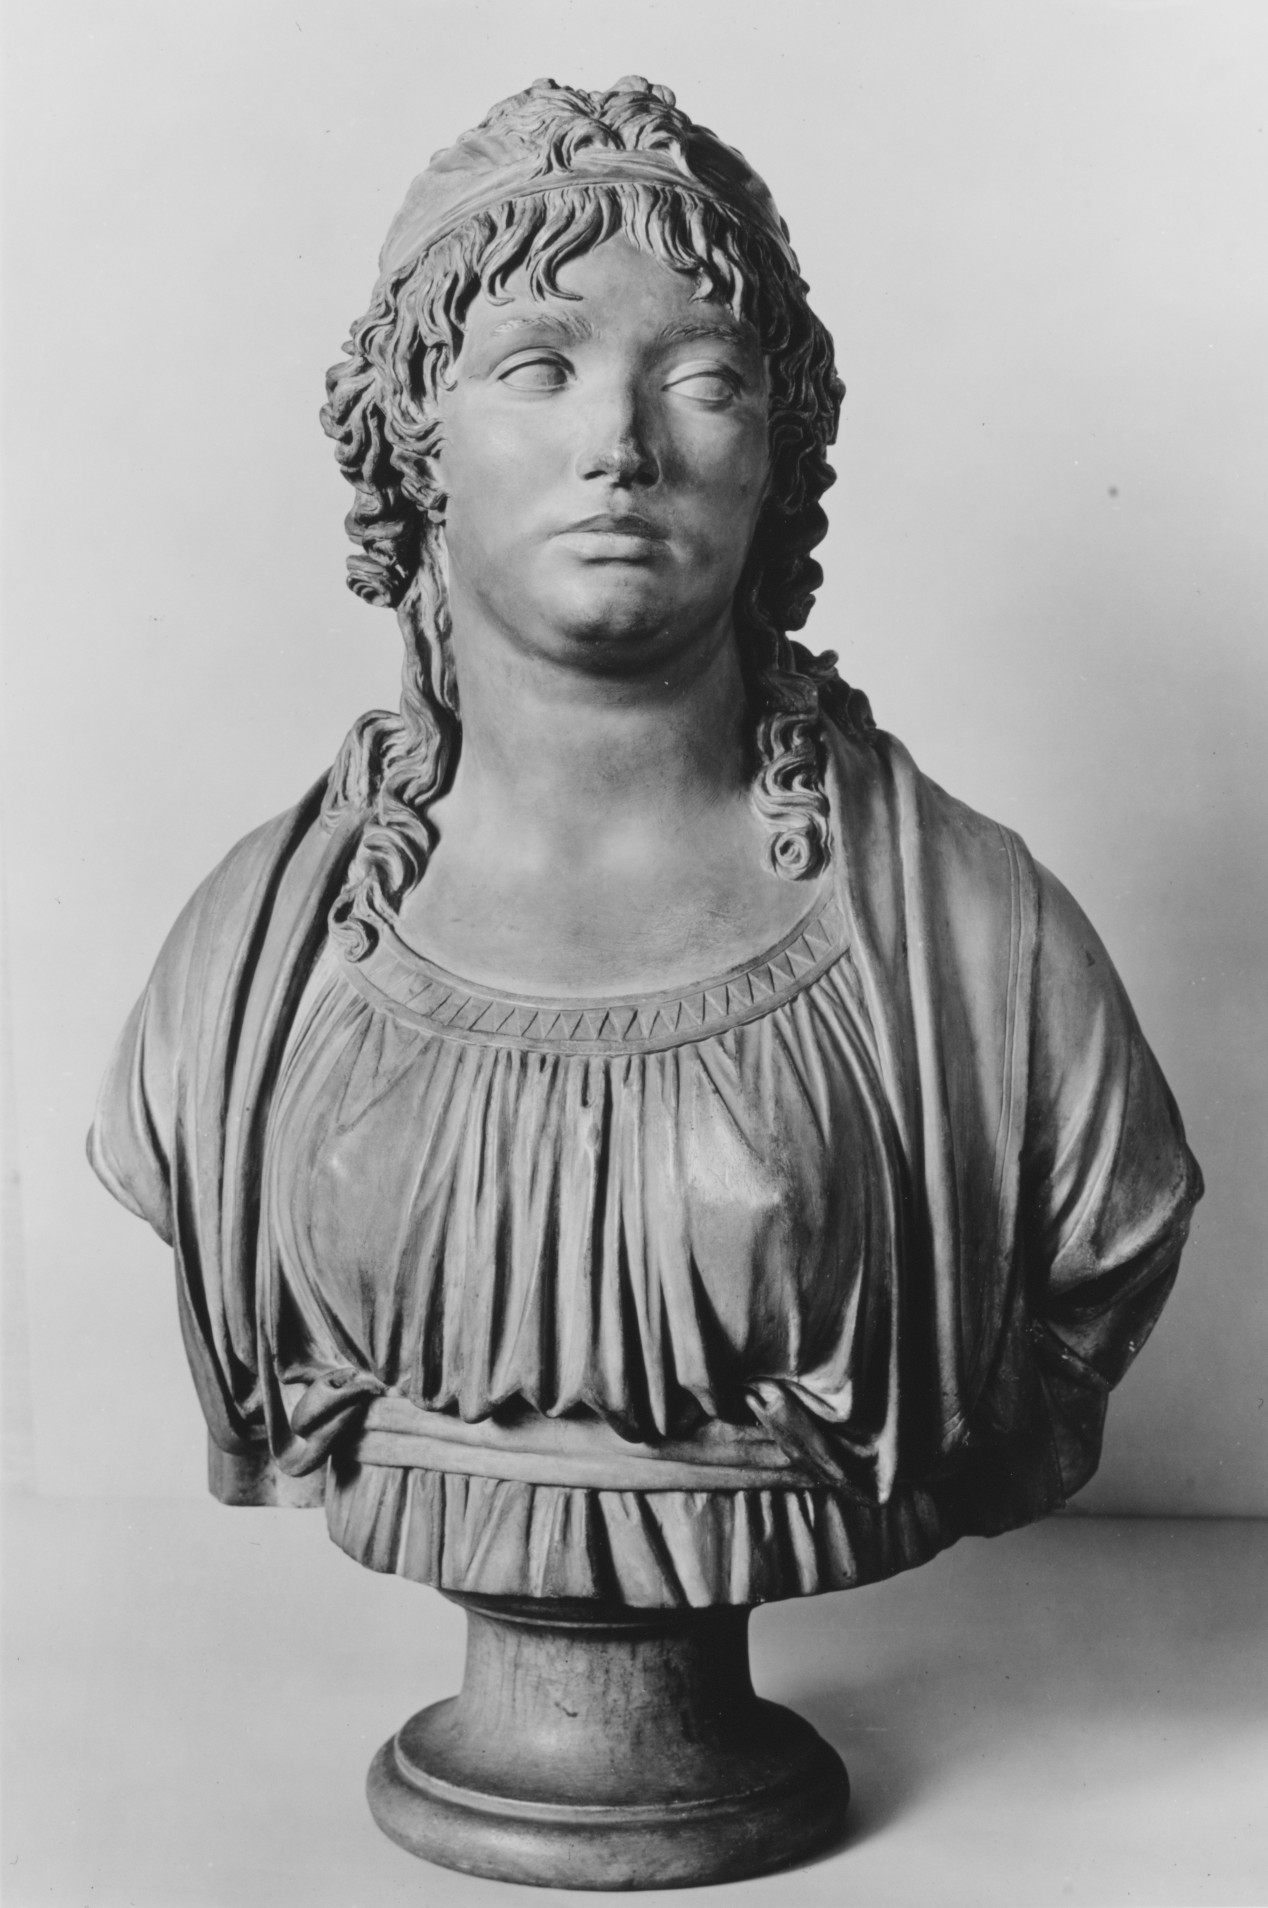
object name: bust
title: Unknown woman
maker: joseph chinard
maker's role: artist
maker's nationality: french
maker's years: 1756-1813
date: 1800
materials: plaster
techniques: tinting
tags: portraits,women